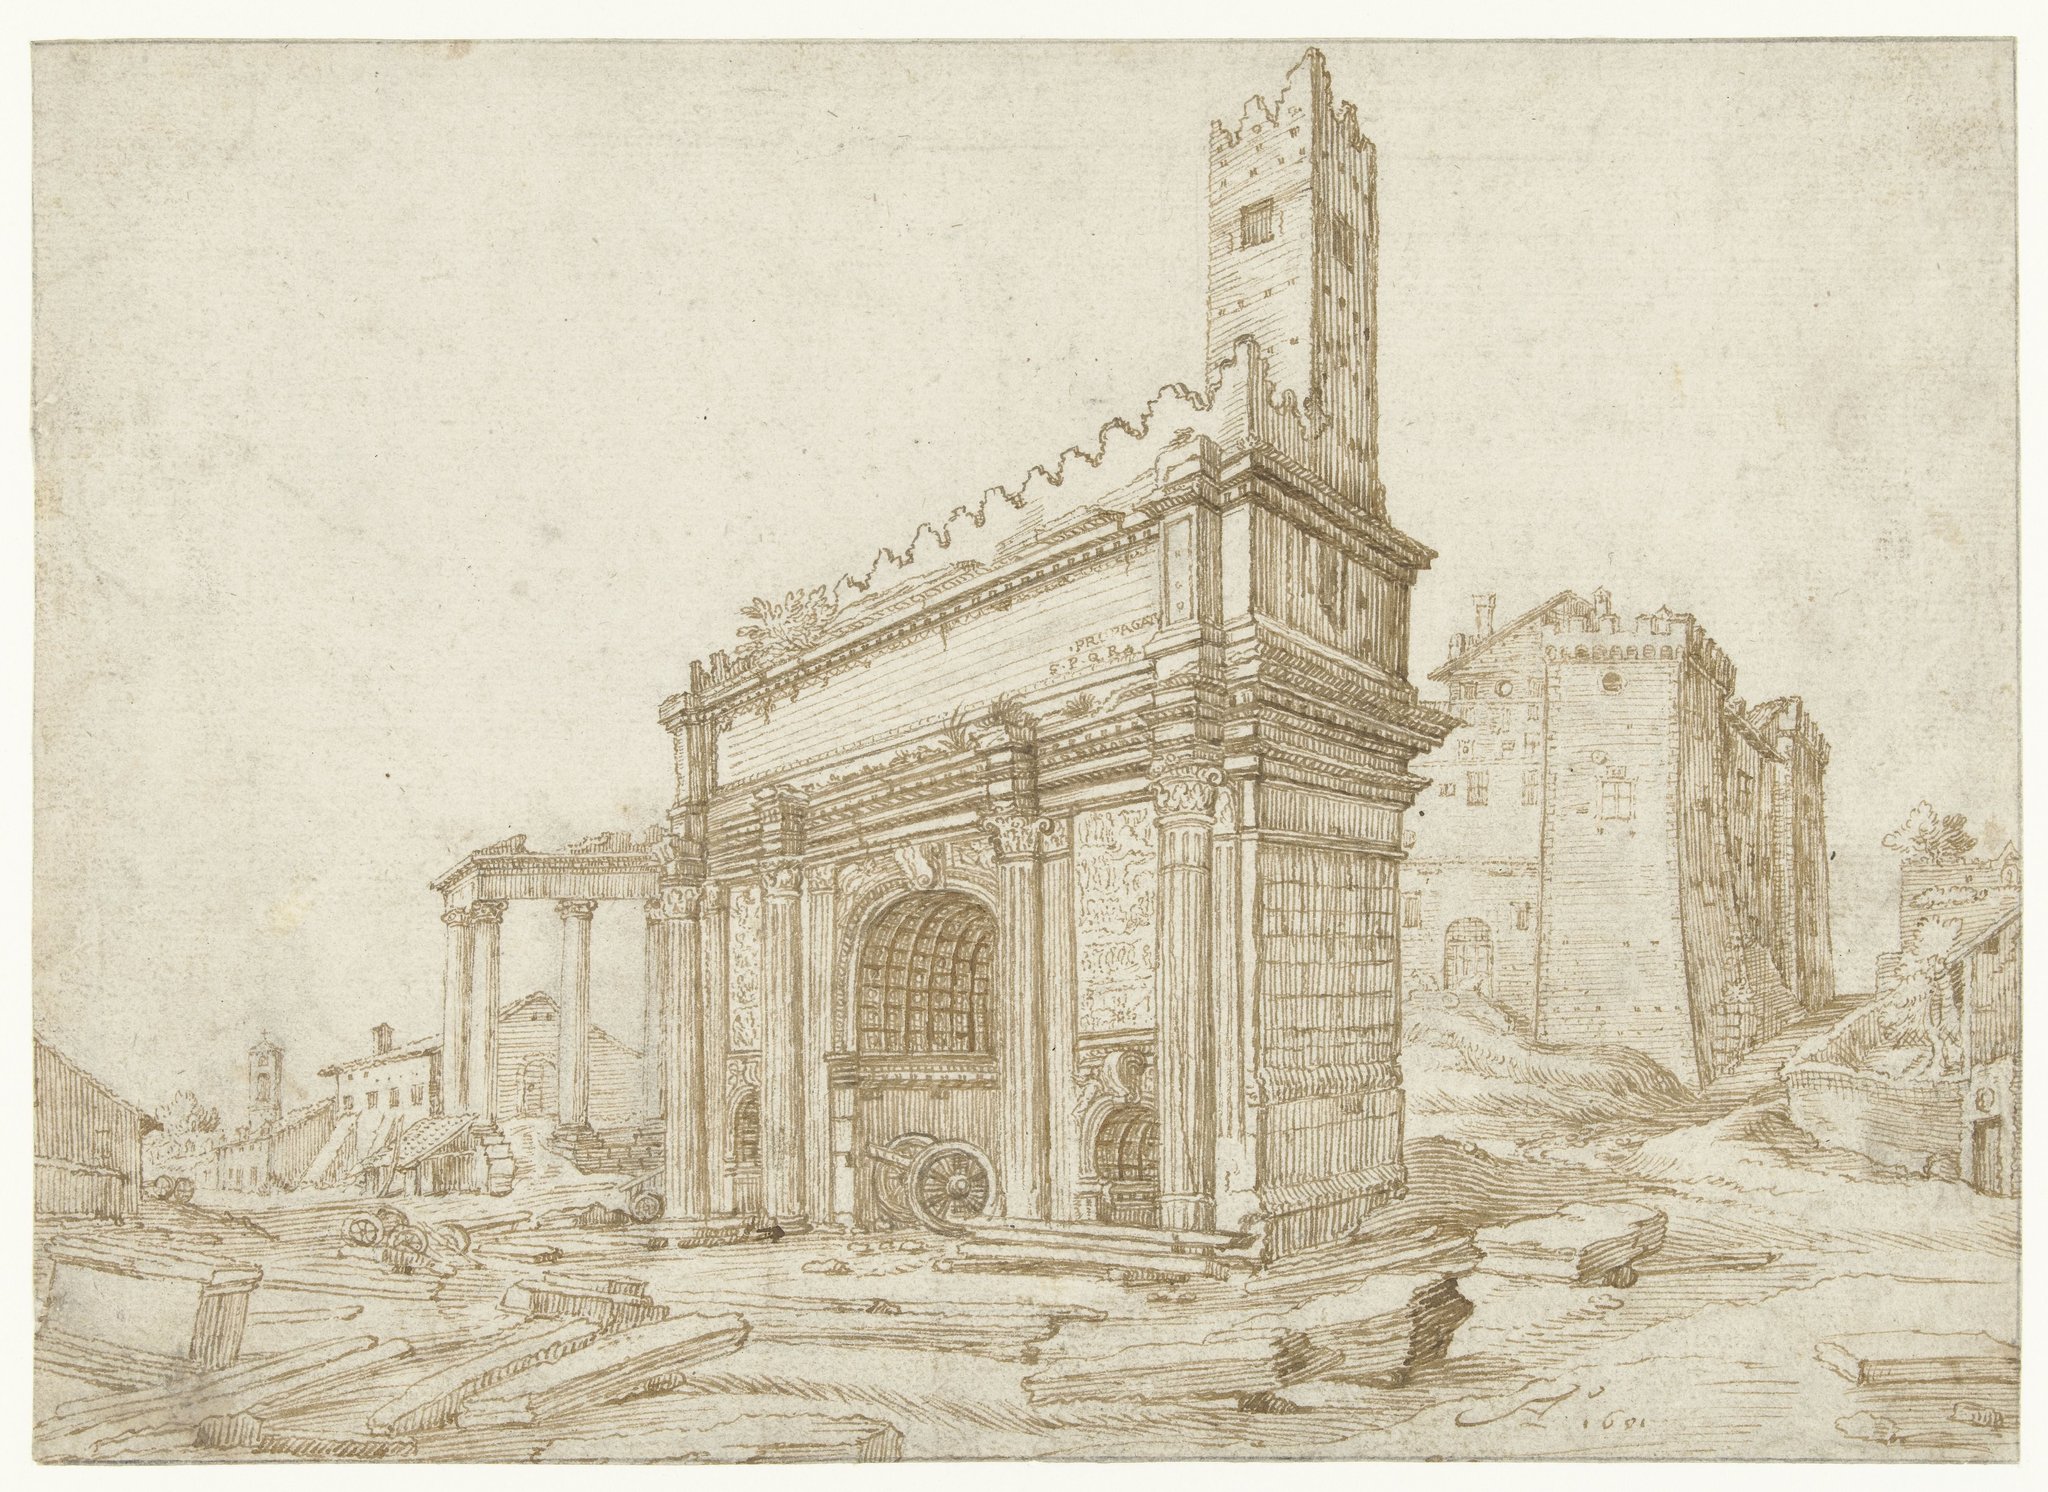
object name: drawing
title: Boog van Septimus Severus te Rome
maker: Anonymous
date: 1601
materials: ink, paper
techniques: pen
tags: ruin of a building ~ architecture, triumphal arch, rome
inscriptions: date